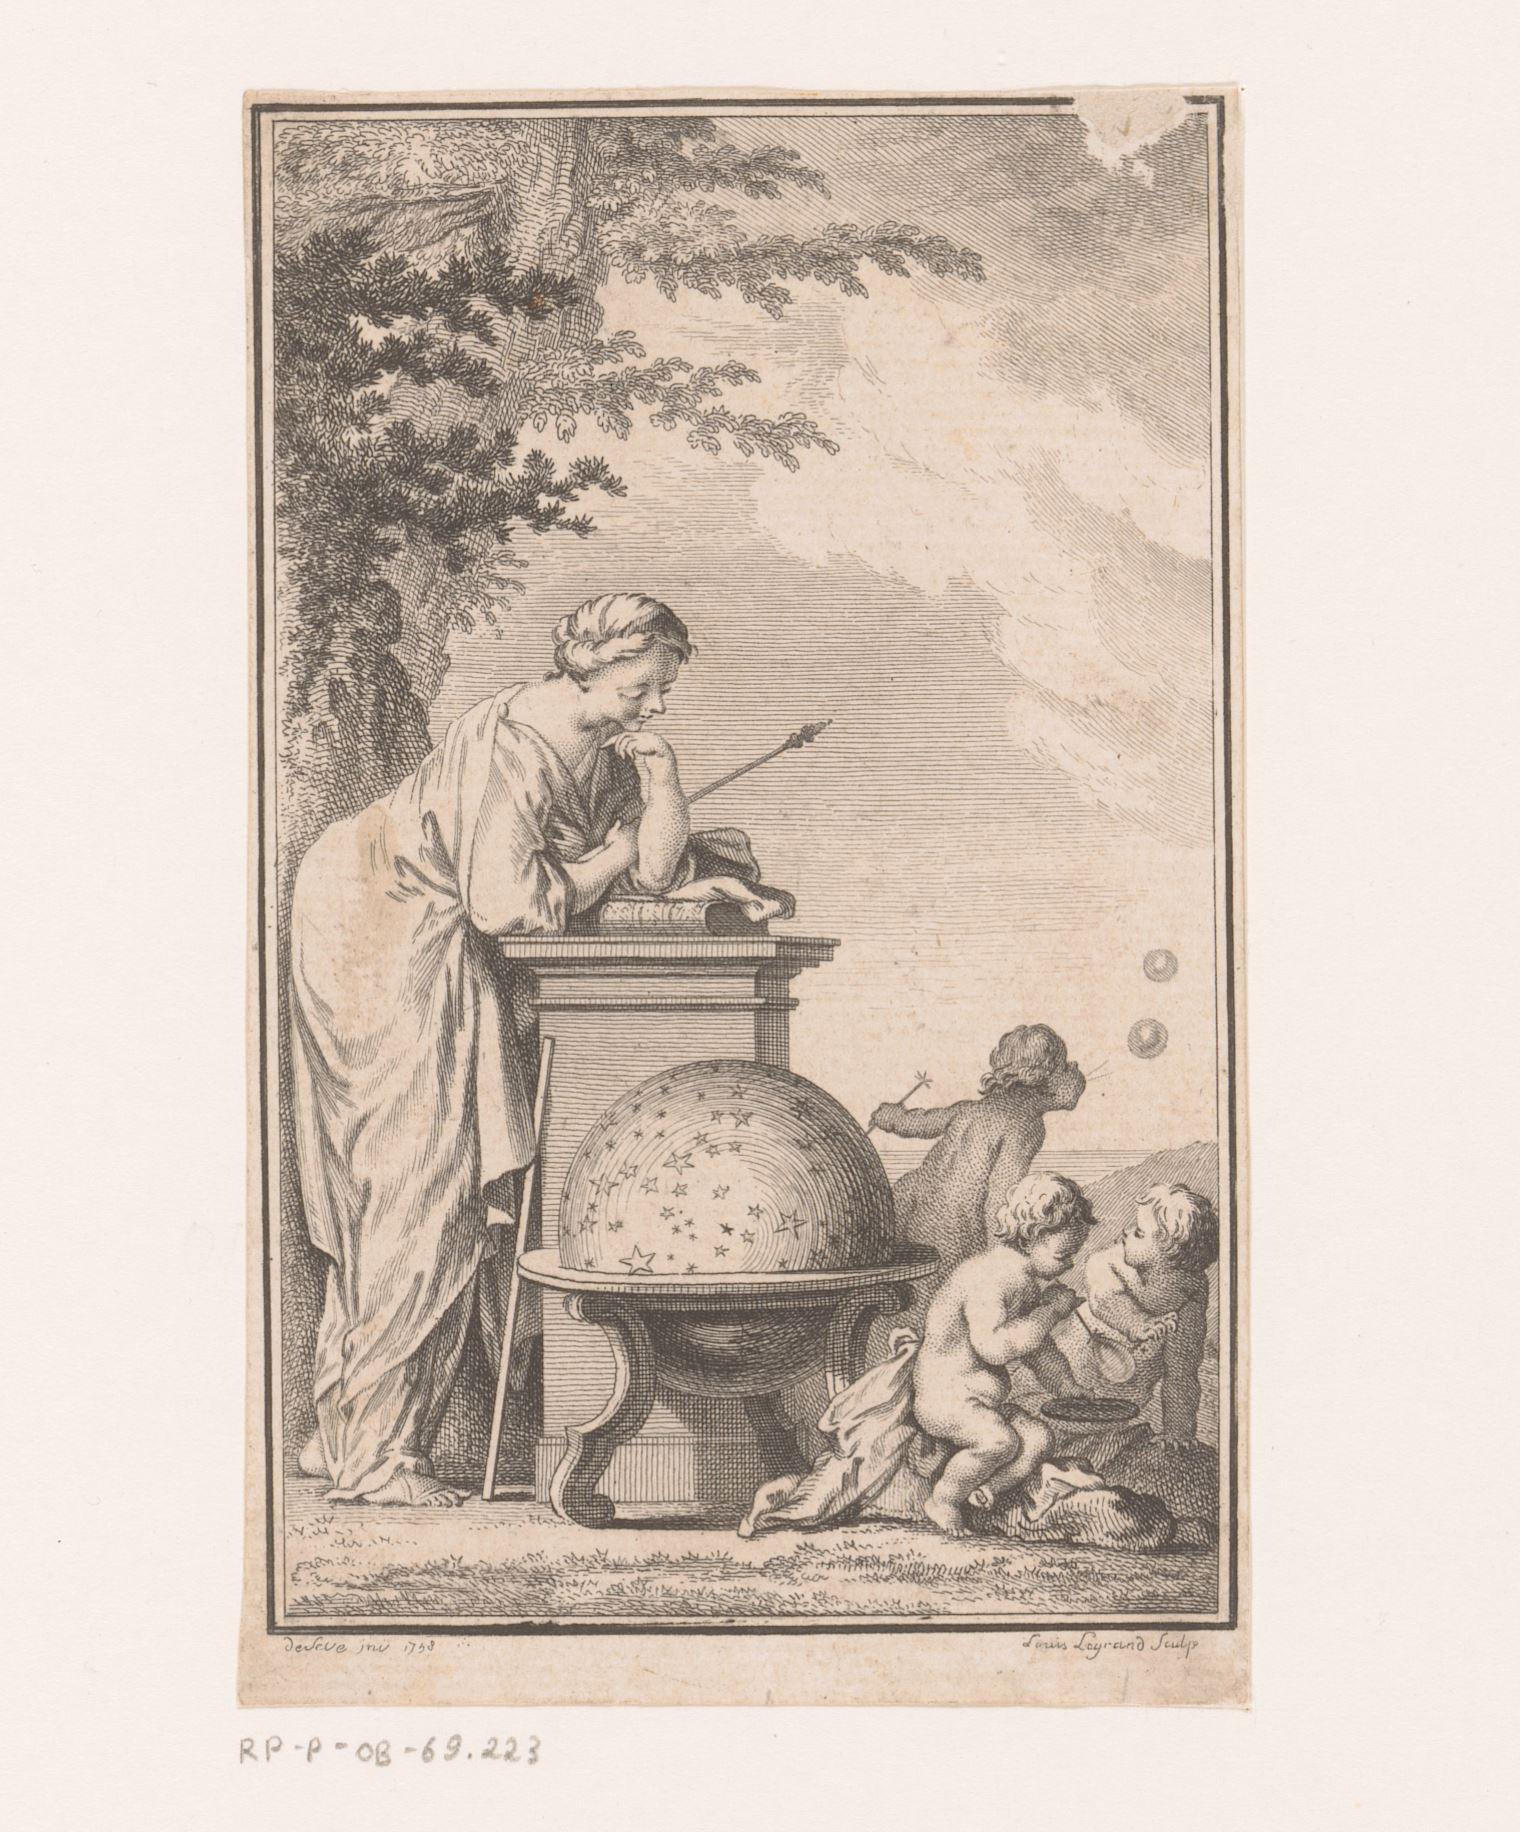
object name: print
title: Mythologische figuur bij een wereldbol en drie bellenblazende putti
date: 1758-1807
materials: paper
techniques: engraving, etching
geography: france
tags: globe, gods ~ classical mythology, (children or putti) blowing bubbles, 'homo bulla' ~ scene symbolizing 'vanitas'